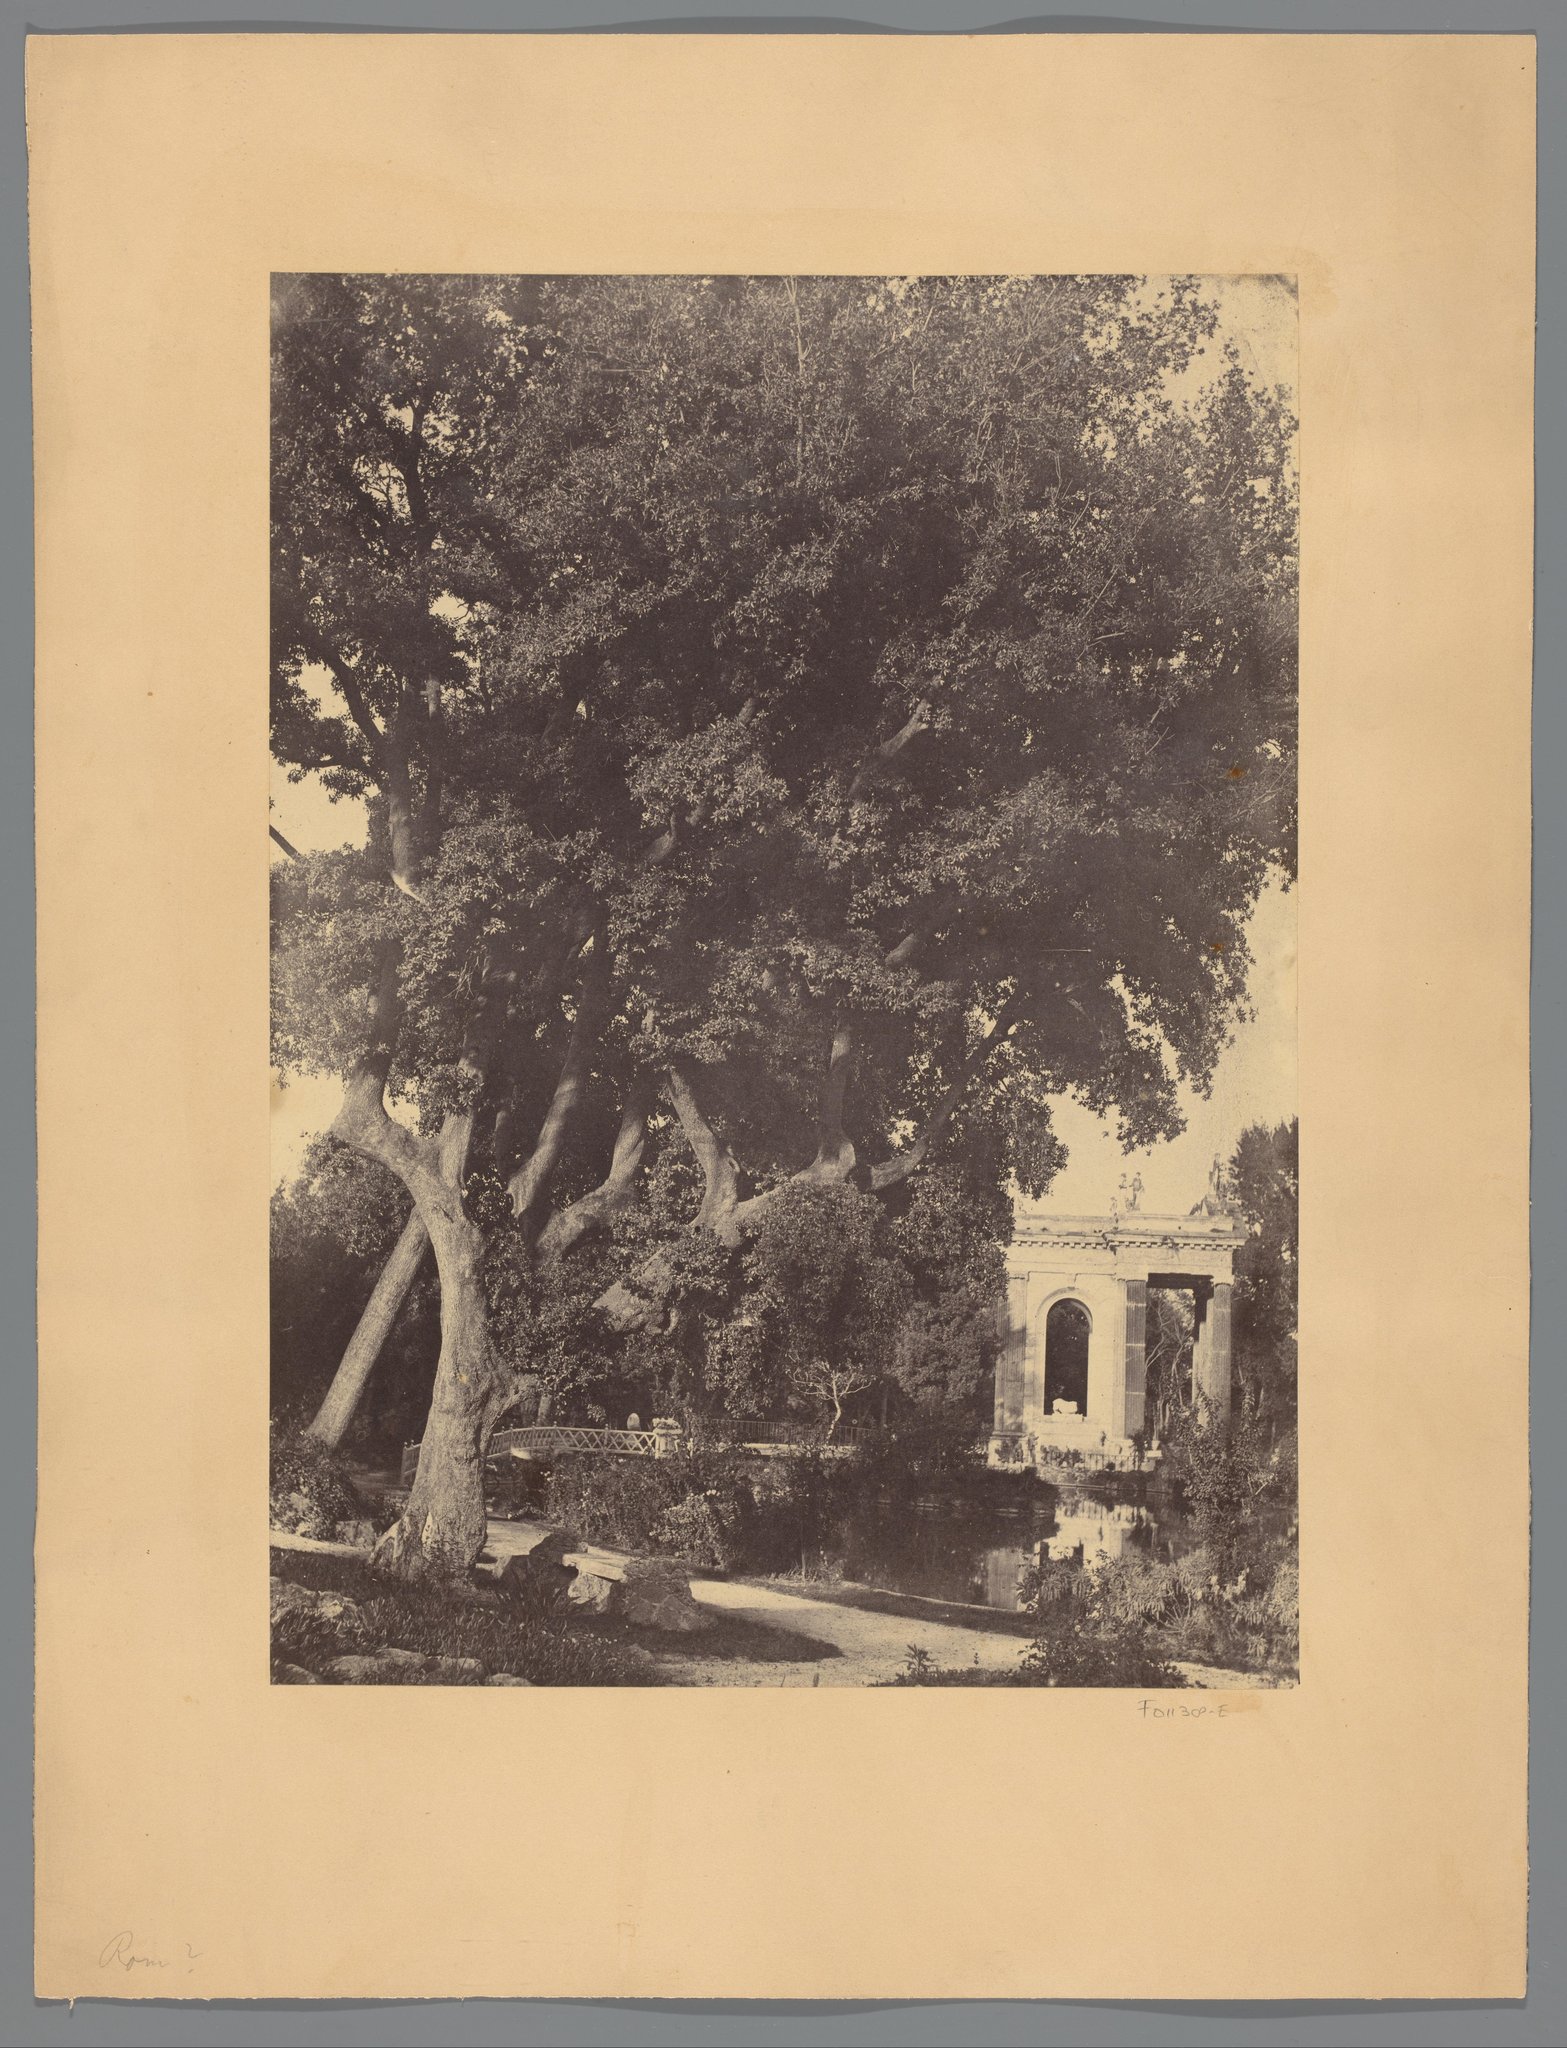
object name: photograph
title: Park met grote boom en classicistisch bouwwerk, vermoedelijk in Italië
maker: Anonymous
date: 1860-1900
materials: photographic support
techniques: albumen print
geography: italy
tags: trees, public gardens, park, italy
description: Onderdeel van Reisalbum met opnames van kunstwerken en bezienswaardigheden in Italië, Griekenland en Frankrijk.